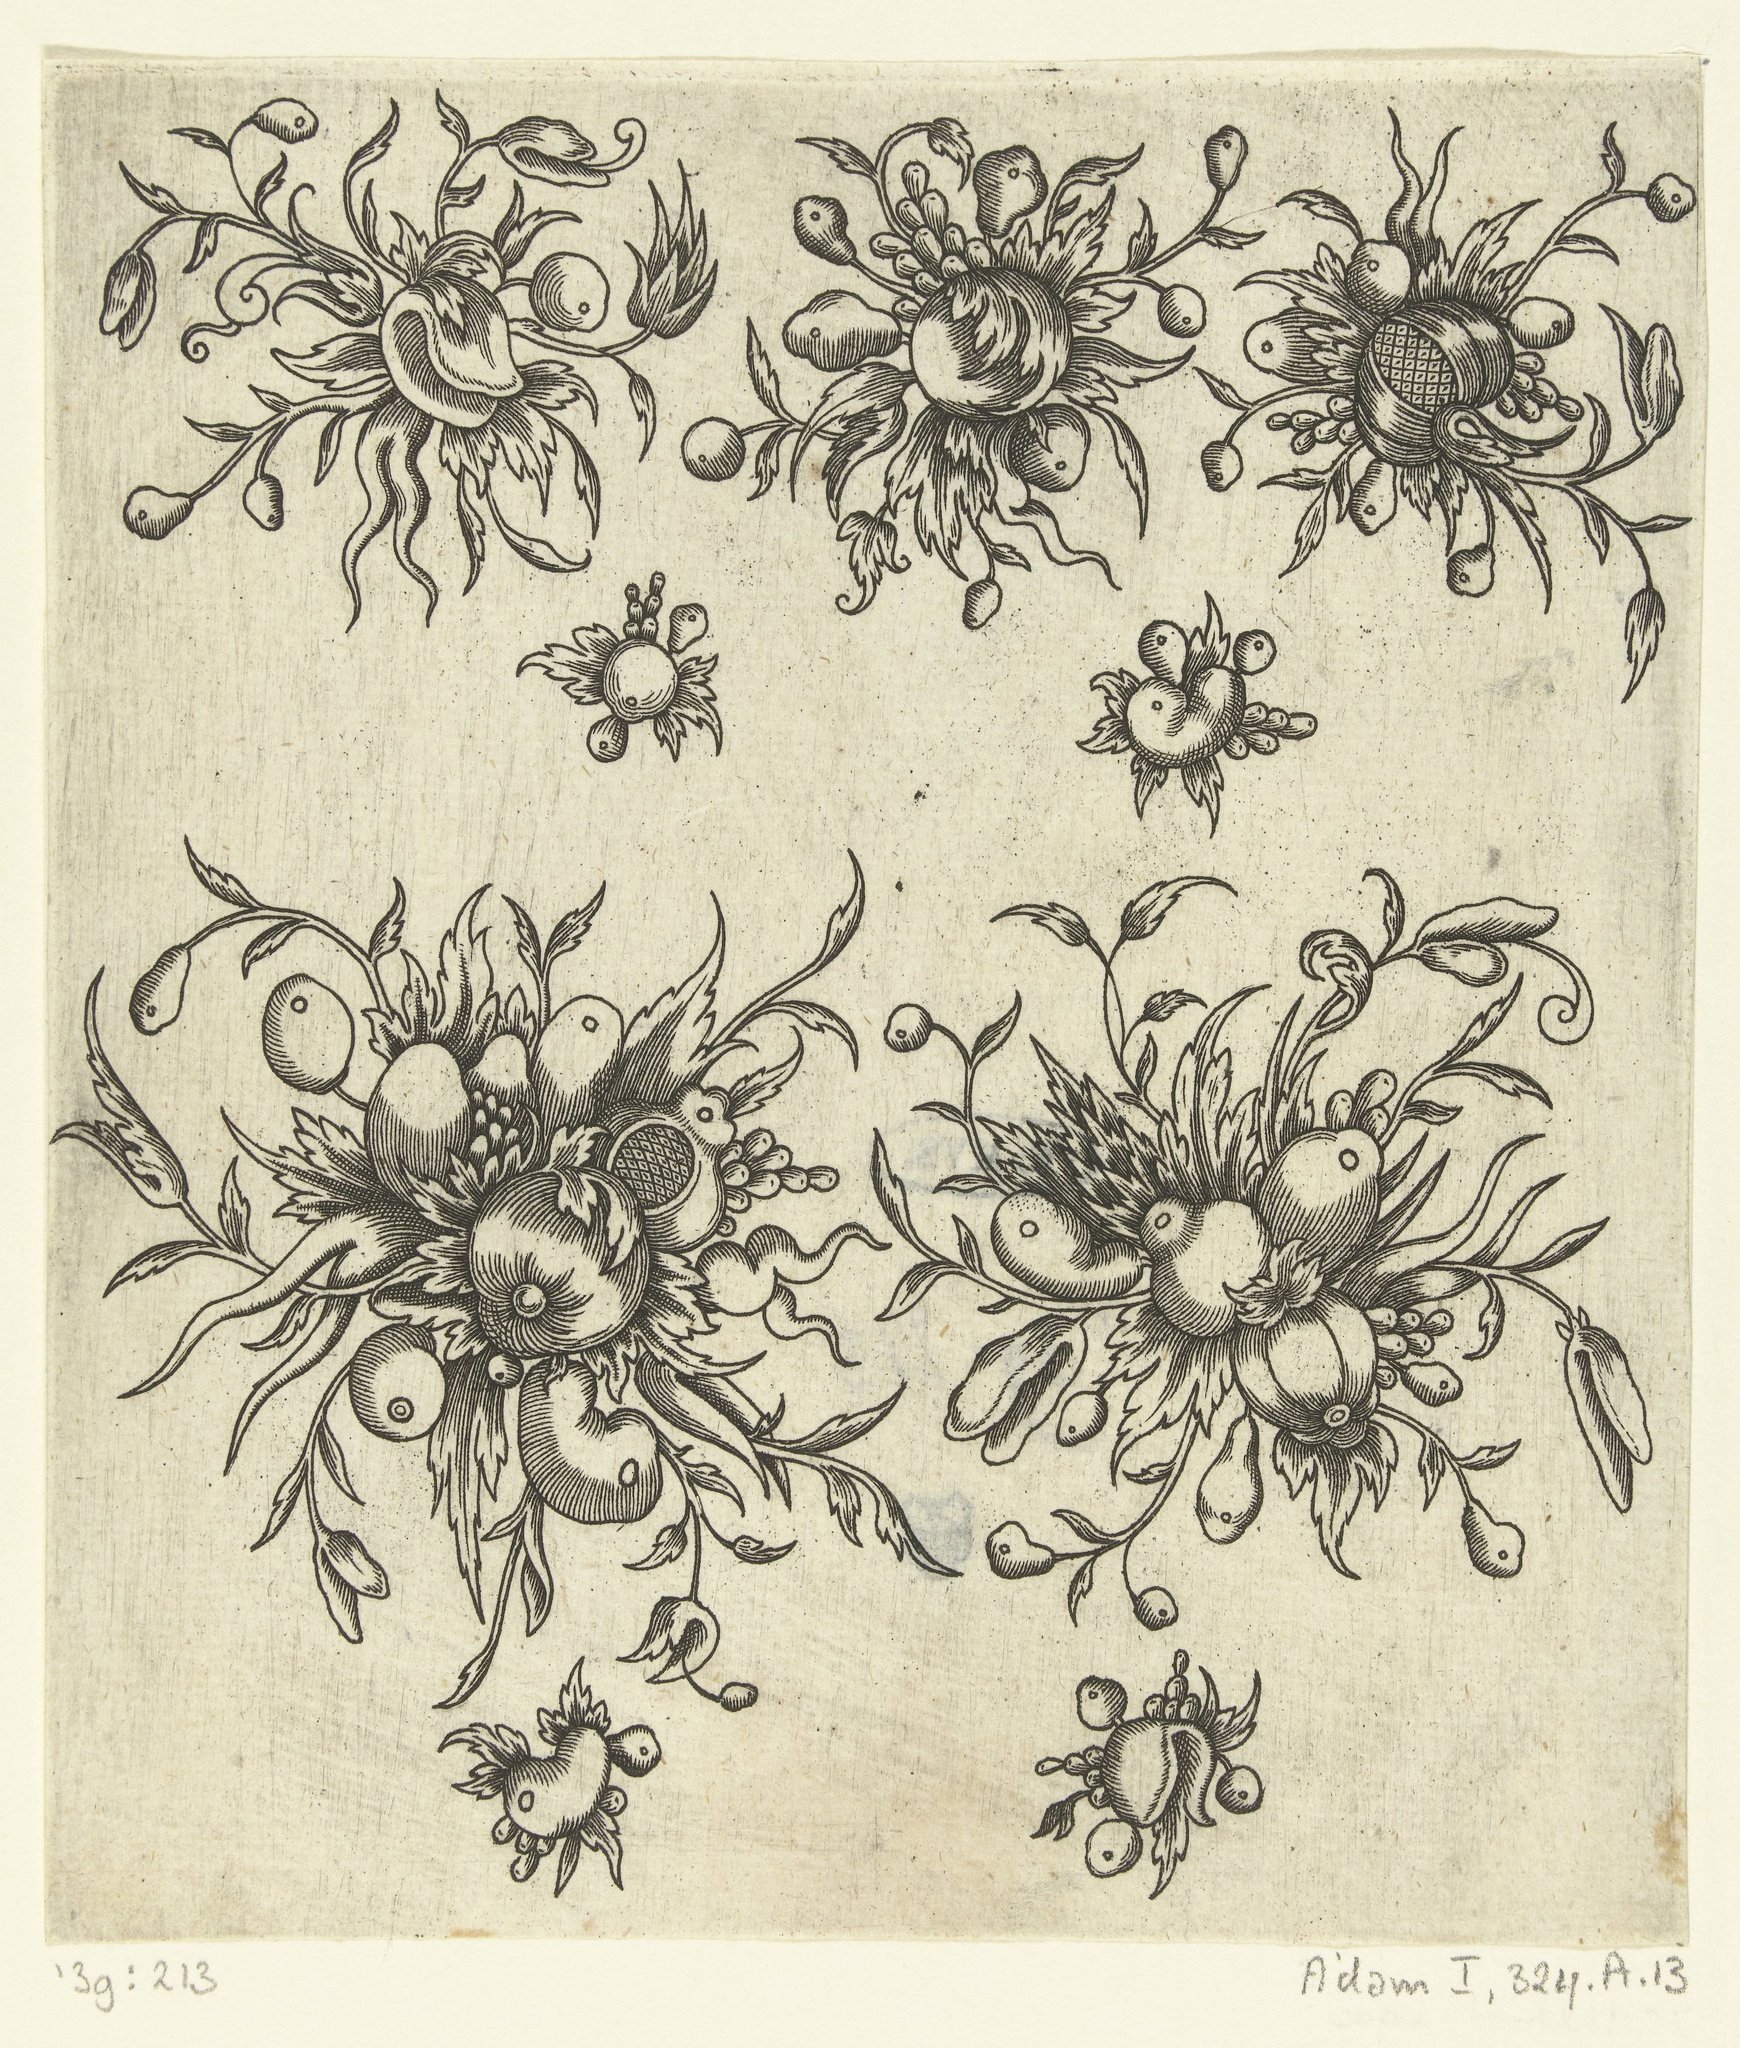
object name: print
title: Veel schoene stucken om te snyden (...) Bekers, bokalen en schalen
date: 1500-1598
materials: paper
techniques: engraving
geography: germany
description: Gelijkzijdige kopieën van de onder Orn Cat I-324 vermelde serie. Titelblad en 13 bladen.